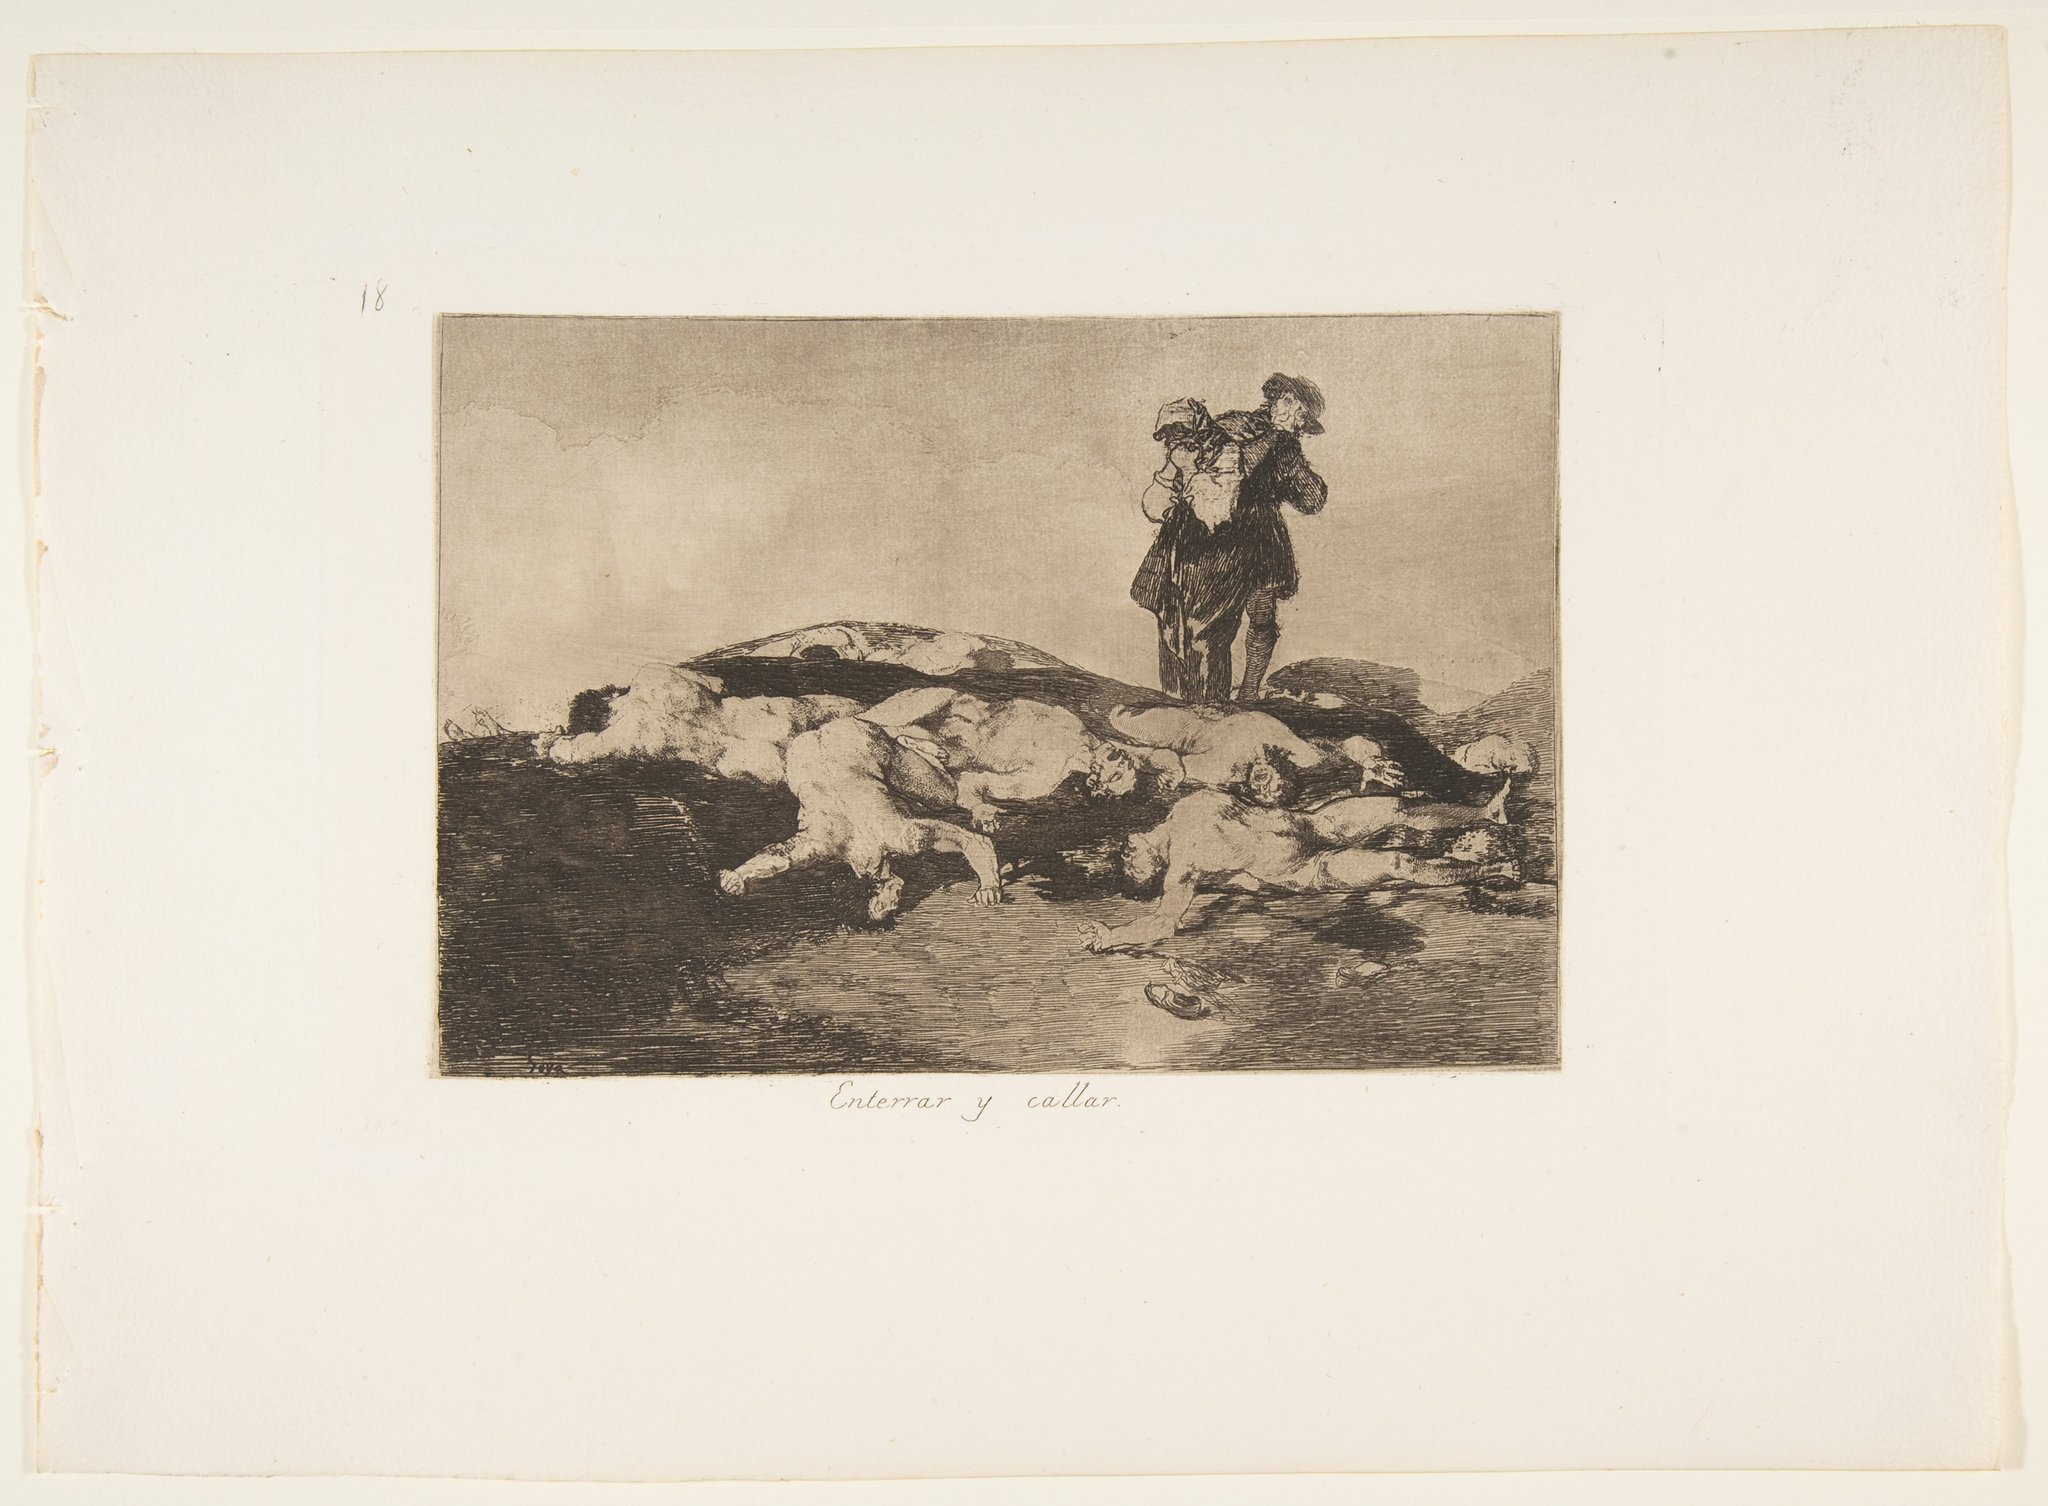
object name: print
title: Plate18 from "The Disasters of War" (Los Desastres de la Guerra): Bury them and keep quiet (Enterrar y callar)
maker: goya (francisco de goya y lucientes)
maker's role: artist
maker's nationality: spanish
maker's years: 1746-1828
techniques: engraving, burnishing, drypoint, etching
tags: corpses,men